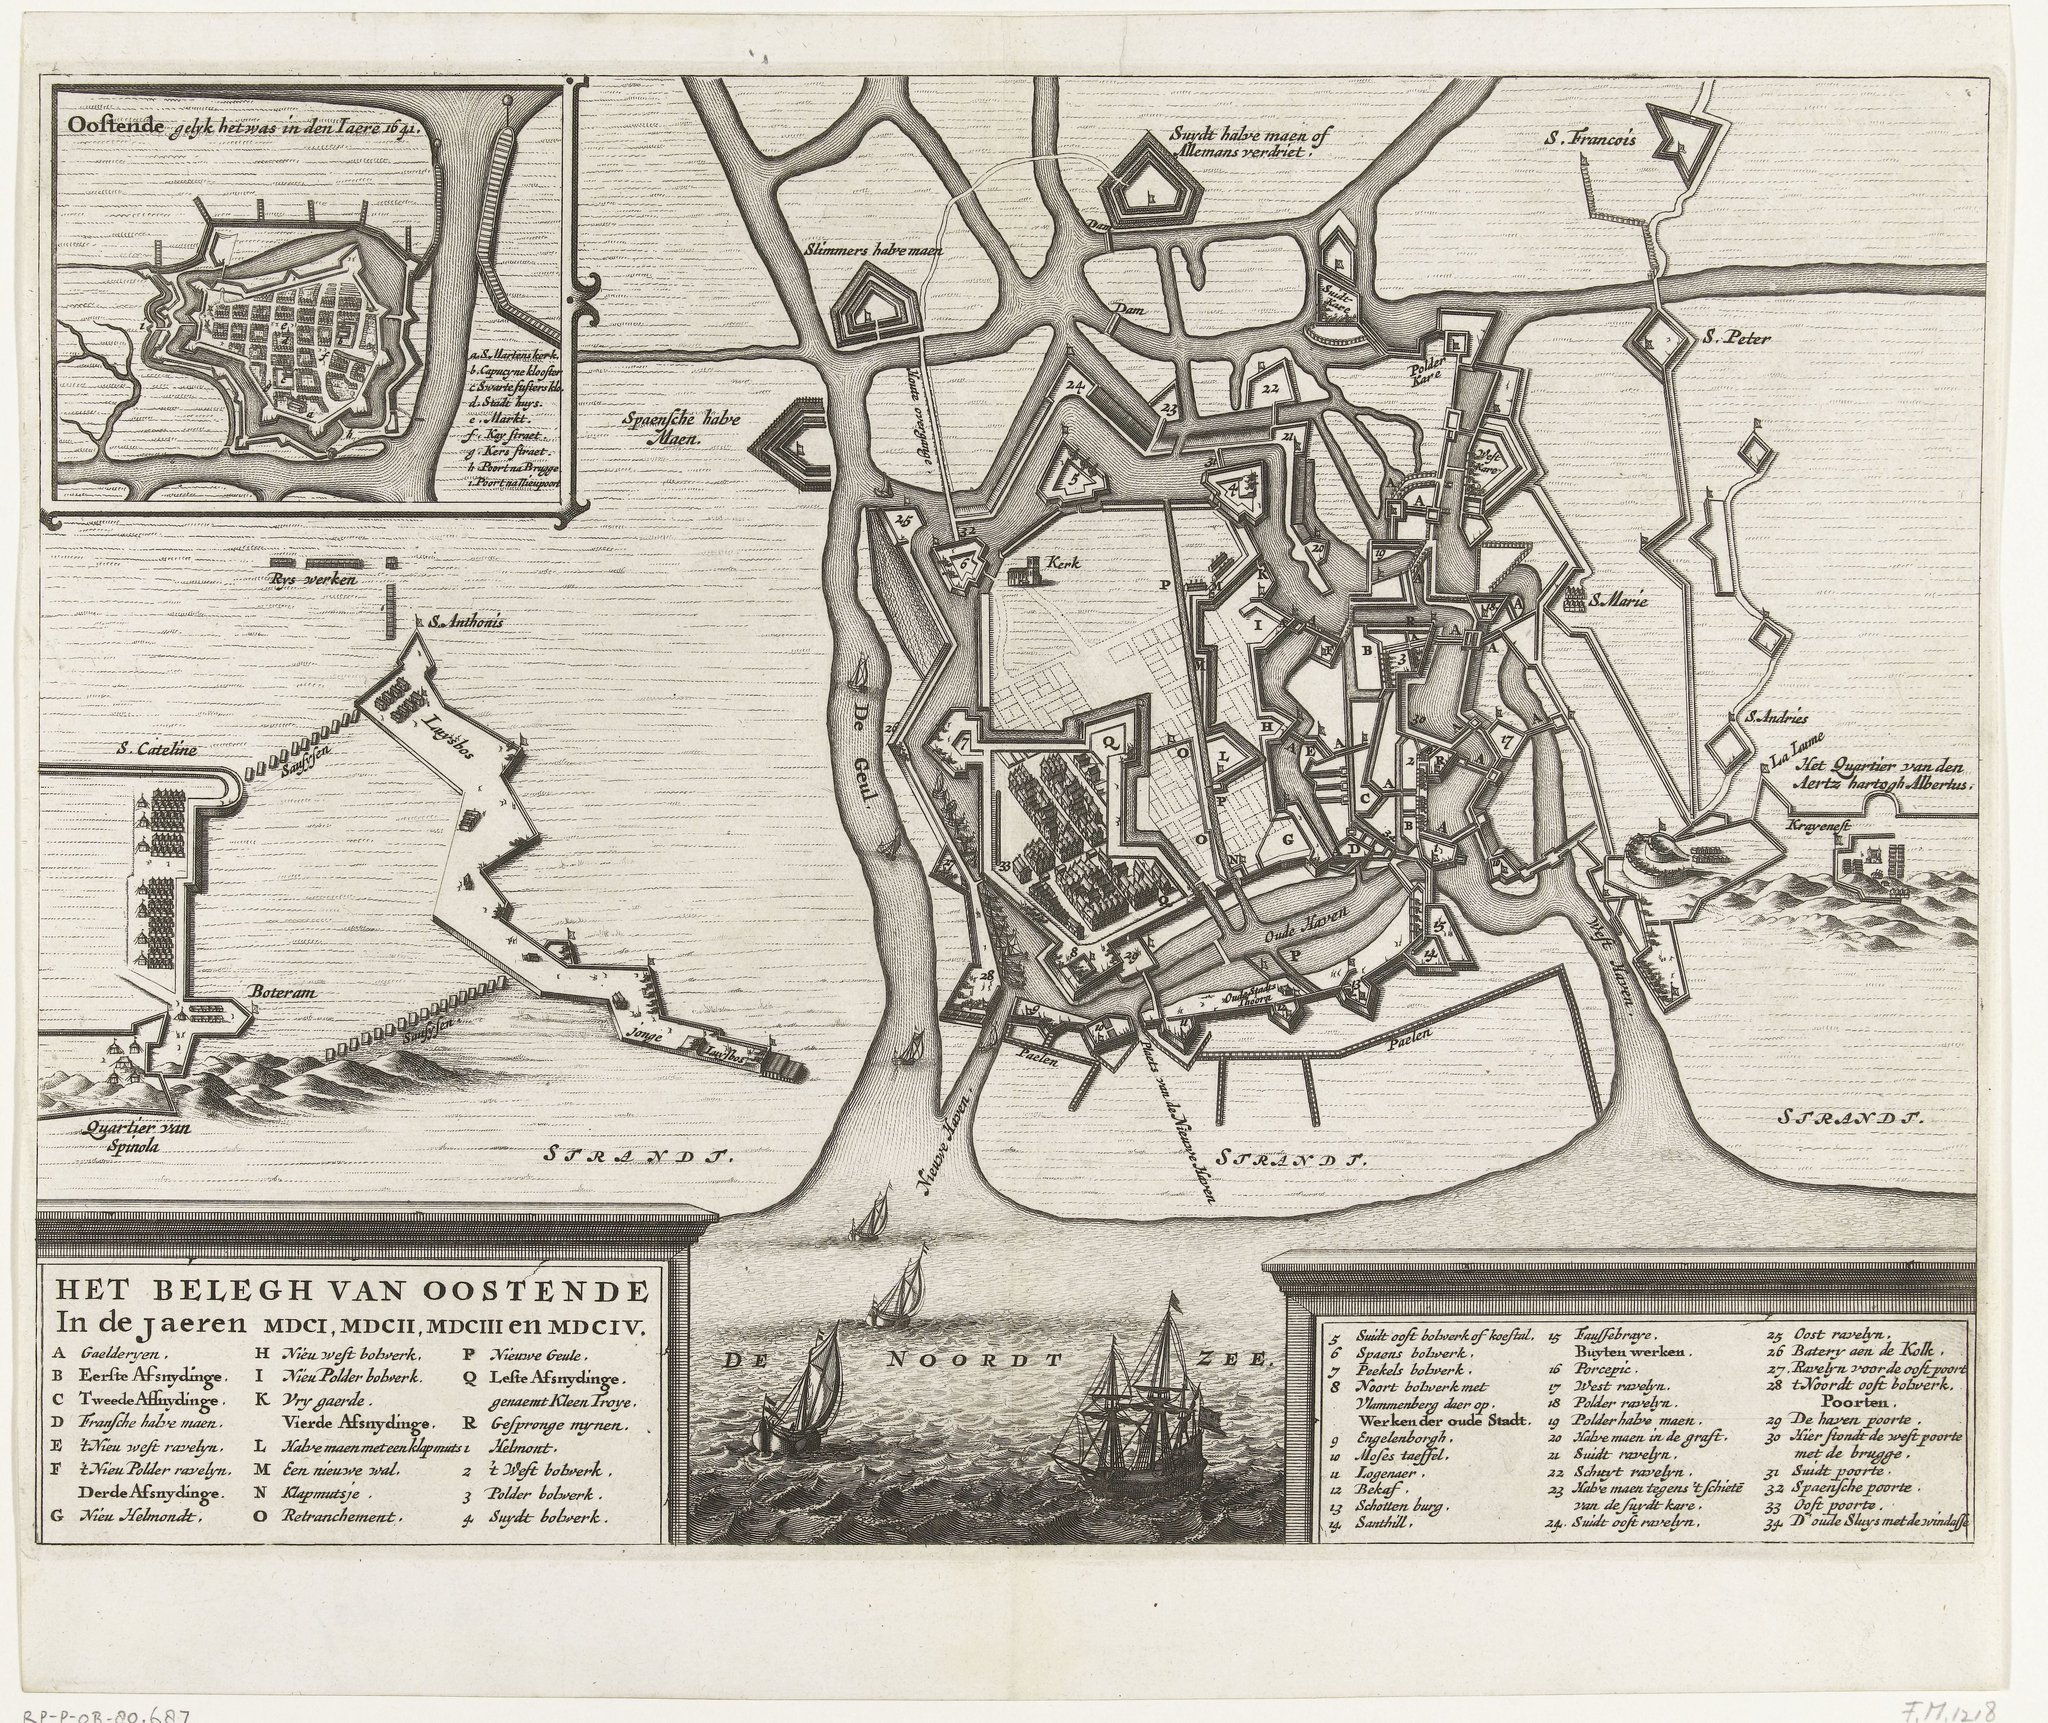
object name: print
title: Het belegh van Oostende in de jaeren MDCI, MDCII, MDCIII en MDCIV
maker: Anonymous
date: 1700-1749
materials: paper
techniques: etching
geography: northern netherlands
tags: siege, position war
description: Beleg van Oostende. Kaart van de verdedigings- en aanvalslinies rondom de stad en in het omliggende gebied, links het kwartier van Spinola, rechts het kwartier van aartshertog Albrecht. Onderaan twee cartouches met de titel en de legenda's A-R en 1-34. Linksboven een inzet met een plattegrond van de stad in 1641.